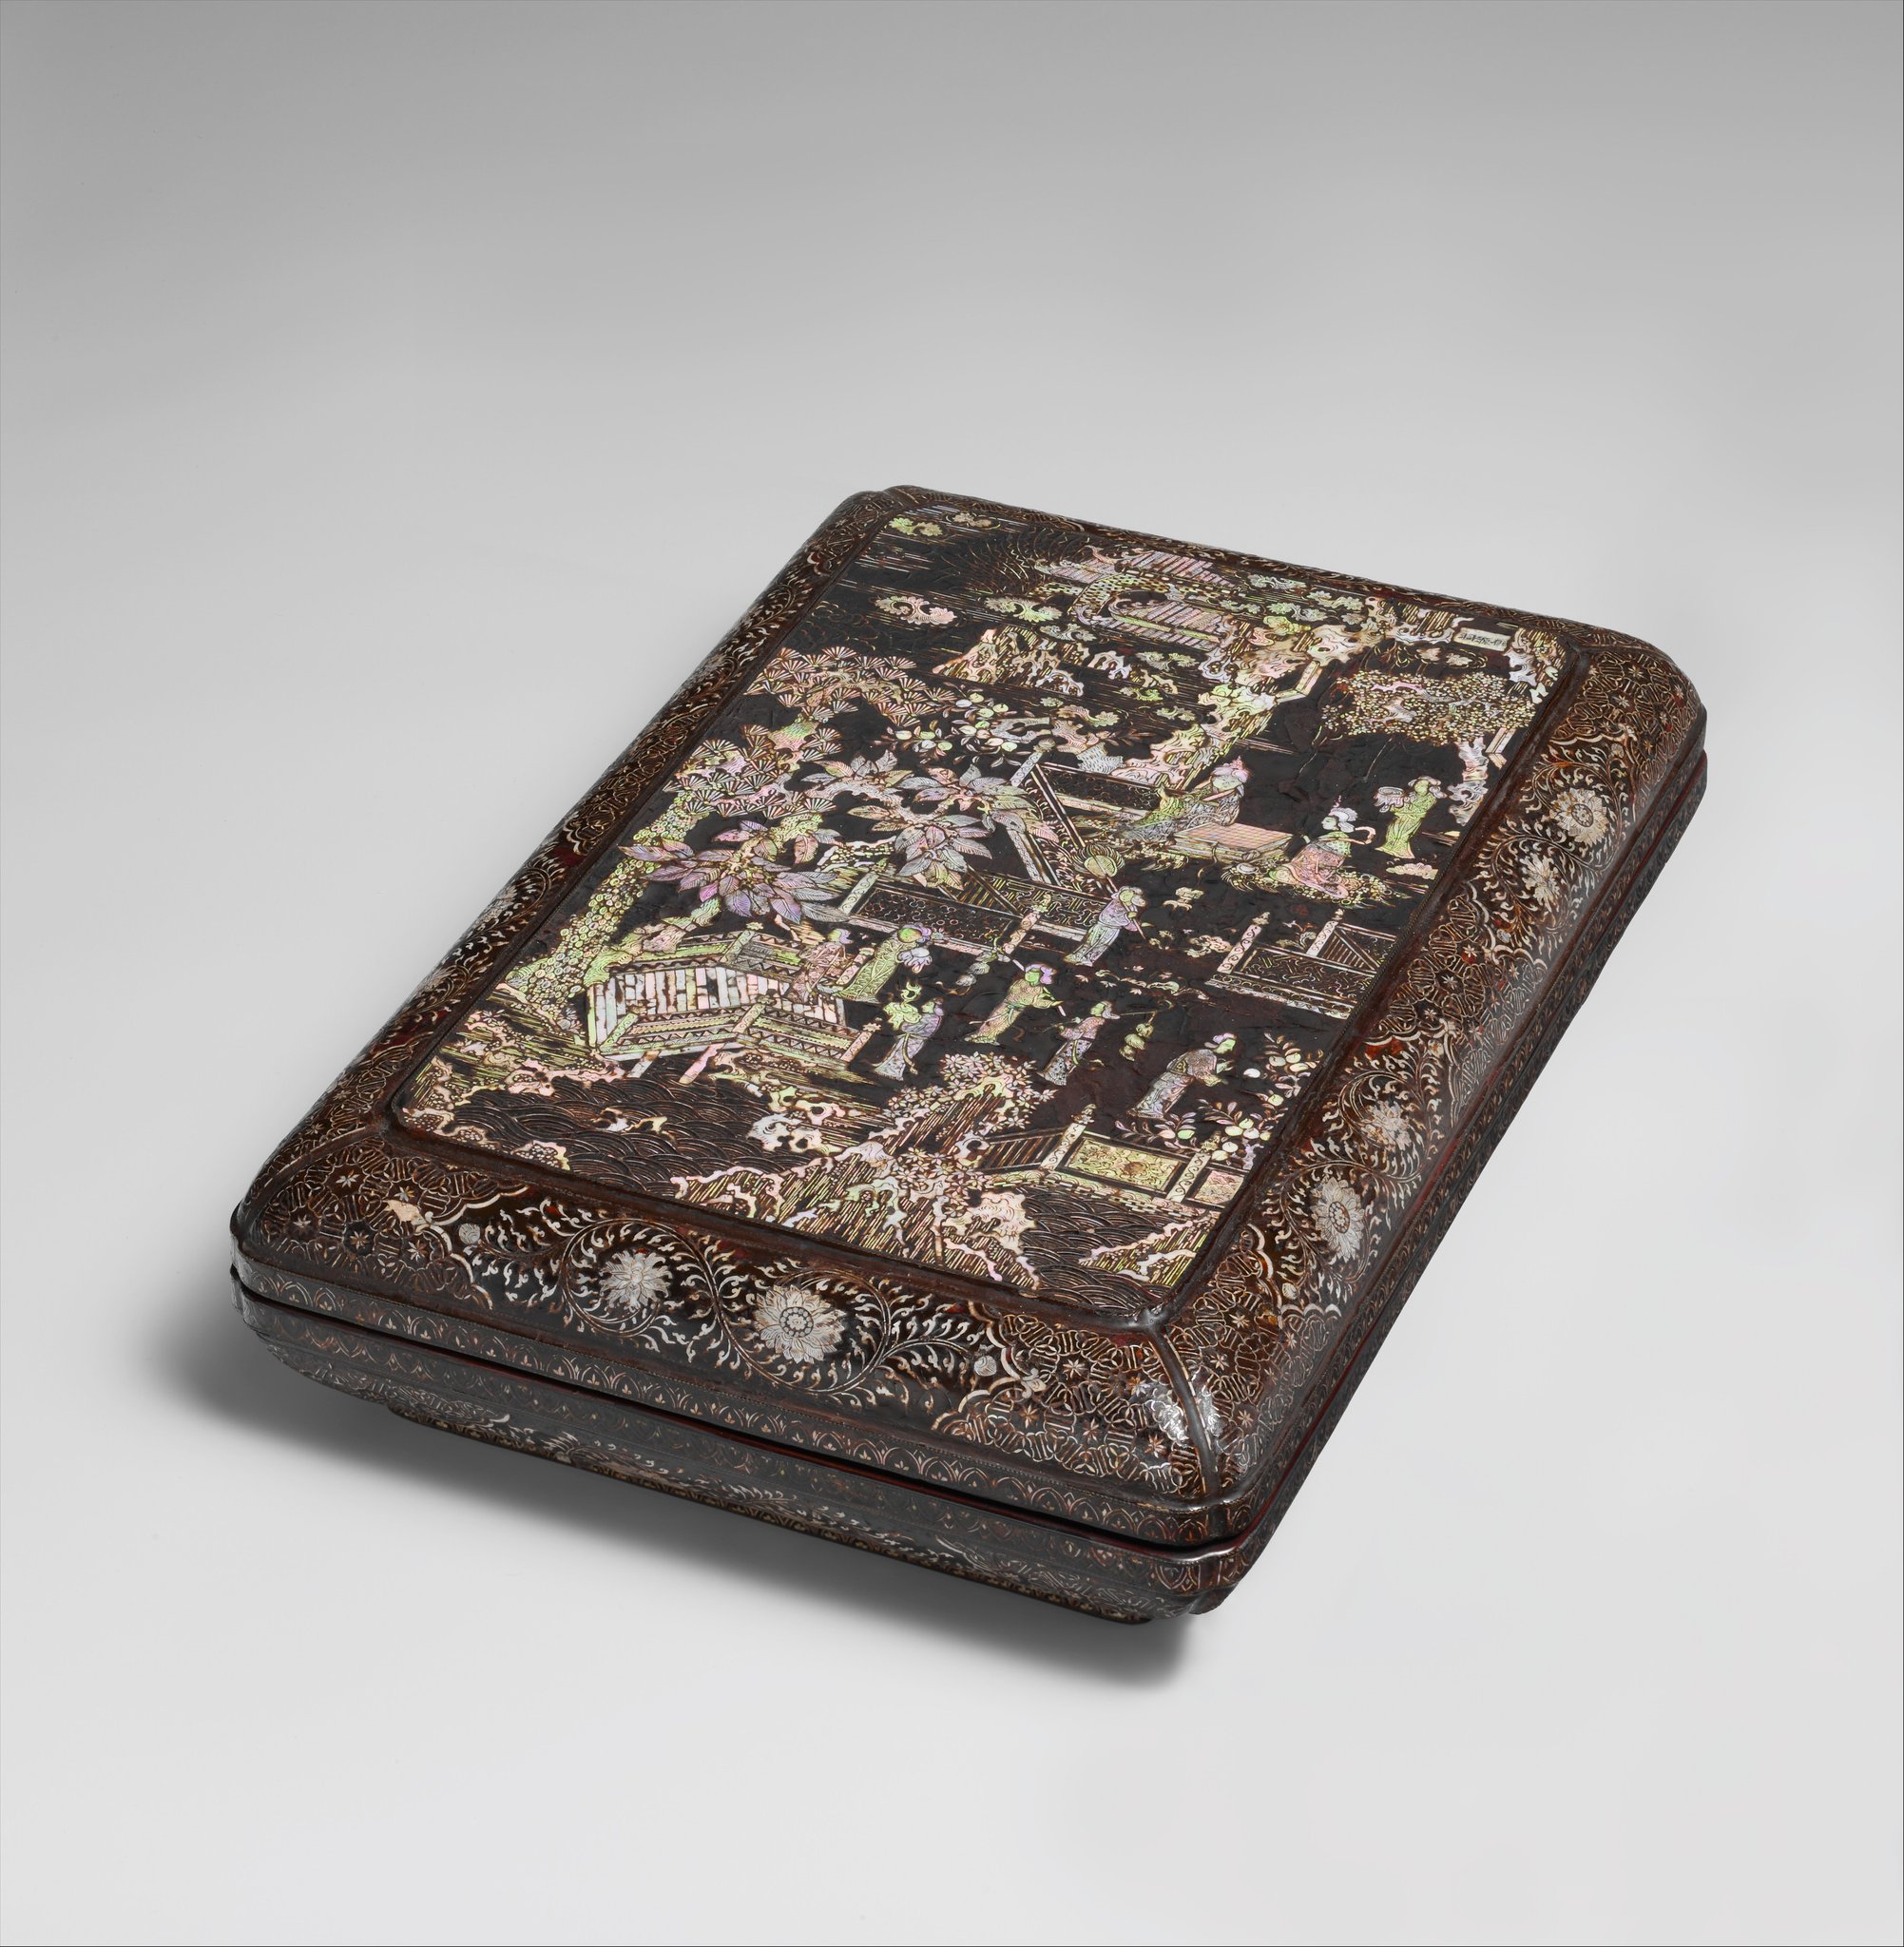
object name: box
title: Box with “peach-blossom grotto”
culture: chinese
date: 1367-1466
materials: lacquer, mother of pearl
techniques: inlay